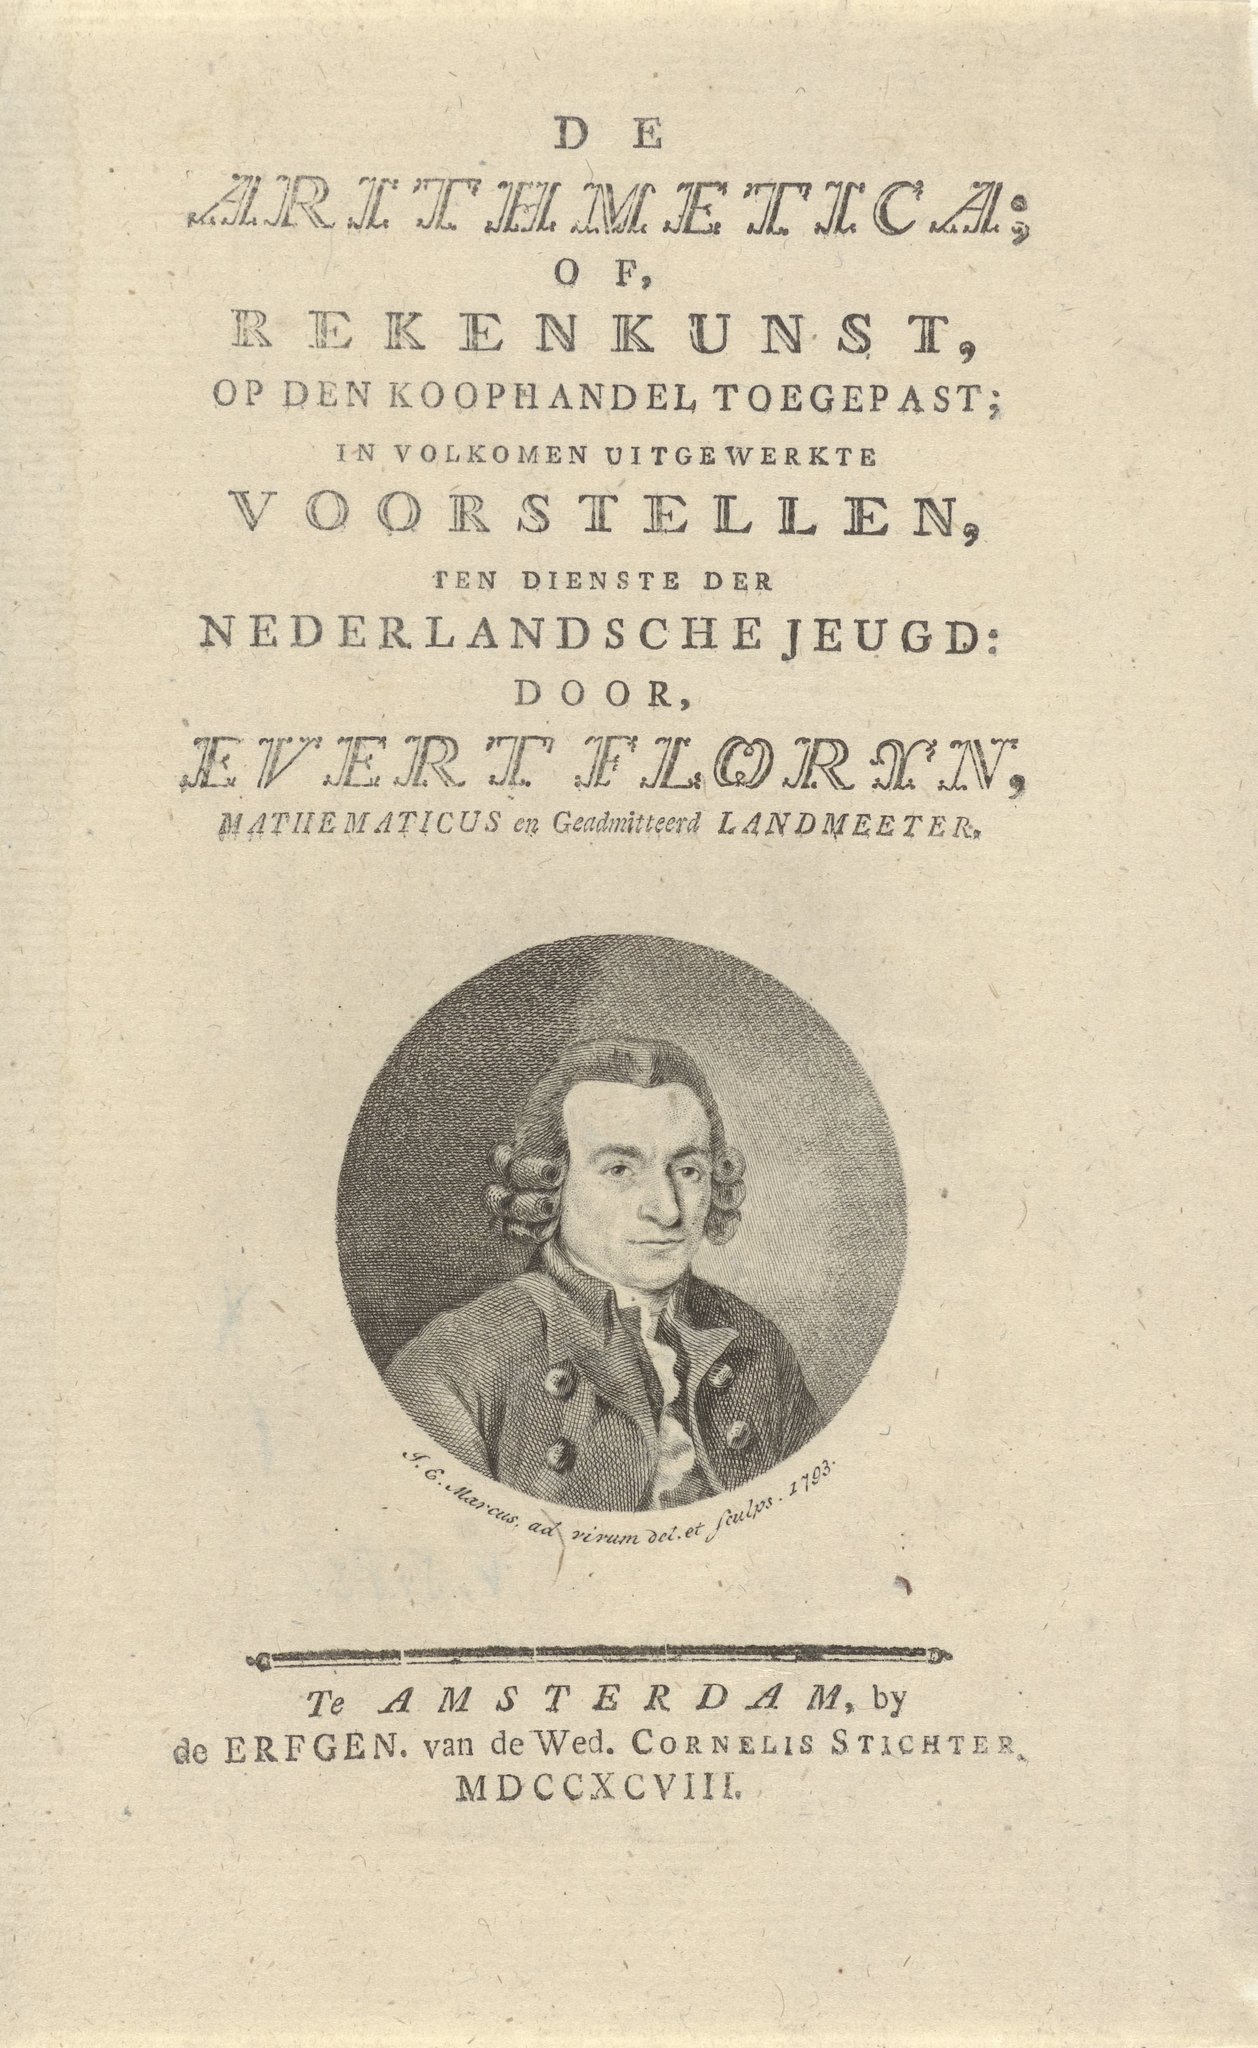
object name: print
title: Titelpagina voor: E. Florijn, De arithmetica, 1793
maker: jacob ernst marcus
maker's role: draughtsman, print maker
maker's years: 1774-1826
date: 1793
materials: paper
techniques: etching, letterpress printing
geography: amsterdam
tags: wiskundige, evert florijn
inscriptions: collector's mark: Lugt 2228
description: Titelpagina voor: Evert Florijn, De arithmetica of rekenkunst, op den koophandel toegepast, in volkomen uitgewerkte voorstellen. Amsterdam, erven Wed. Cornelis Stichter, 1798.